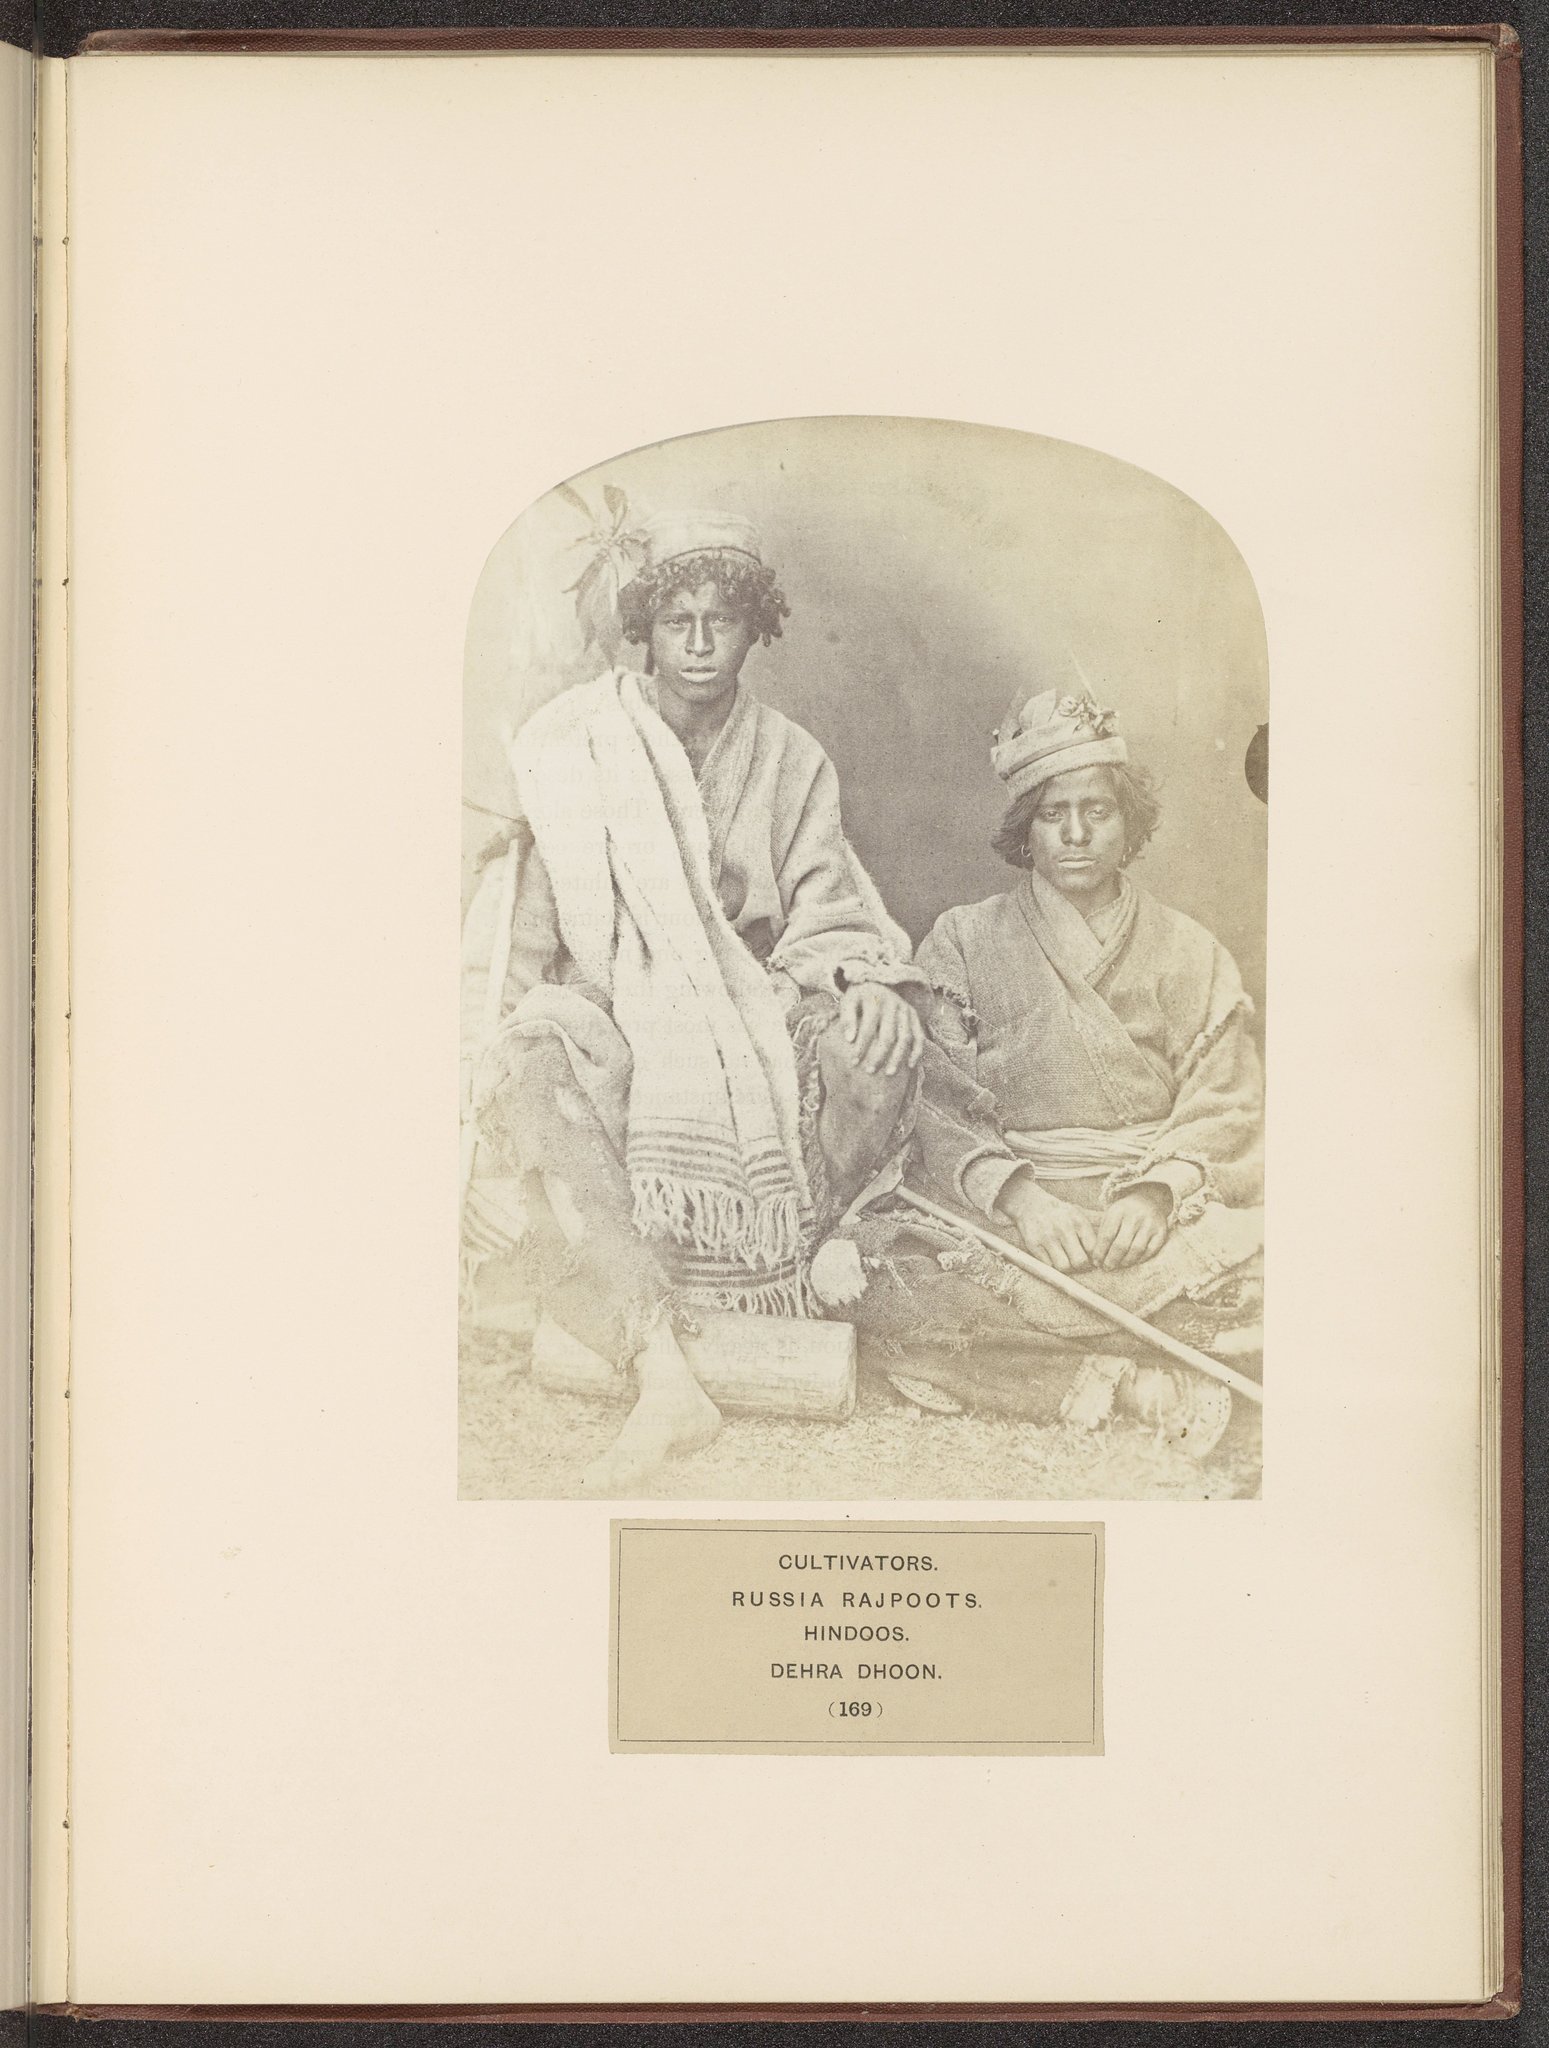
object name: page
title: Portrait of two farmers from the Rajput community of Dehradun, Uttarakhand, India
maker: Anonymous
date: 1858-1868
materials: photographic support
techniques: albumen print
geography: dehradun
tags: farmers, human races; peoples; nationalities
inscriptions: inscription: ‘CULTIVATORS./ RUSSIA RAJPOOTS./ HINDOOS./ DEHRA DHOON.’, number: ‘(169)’